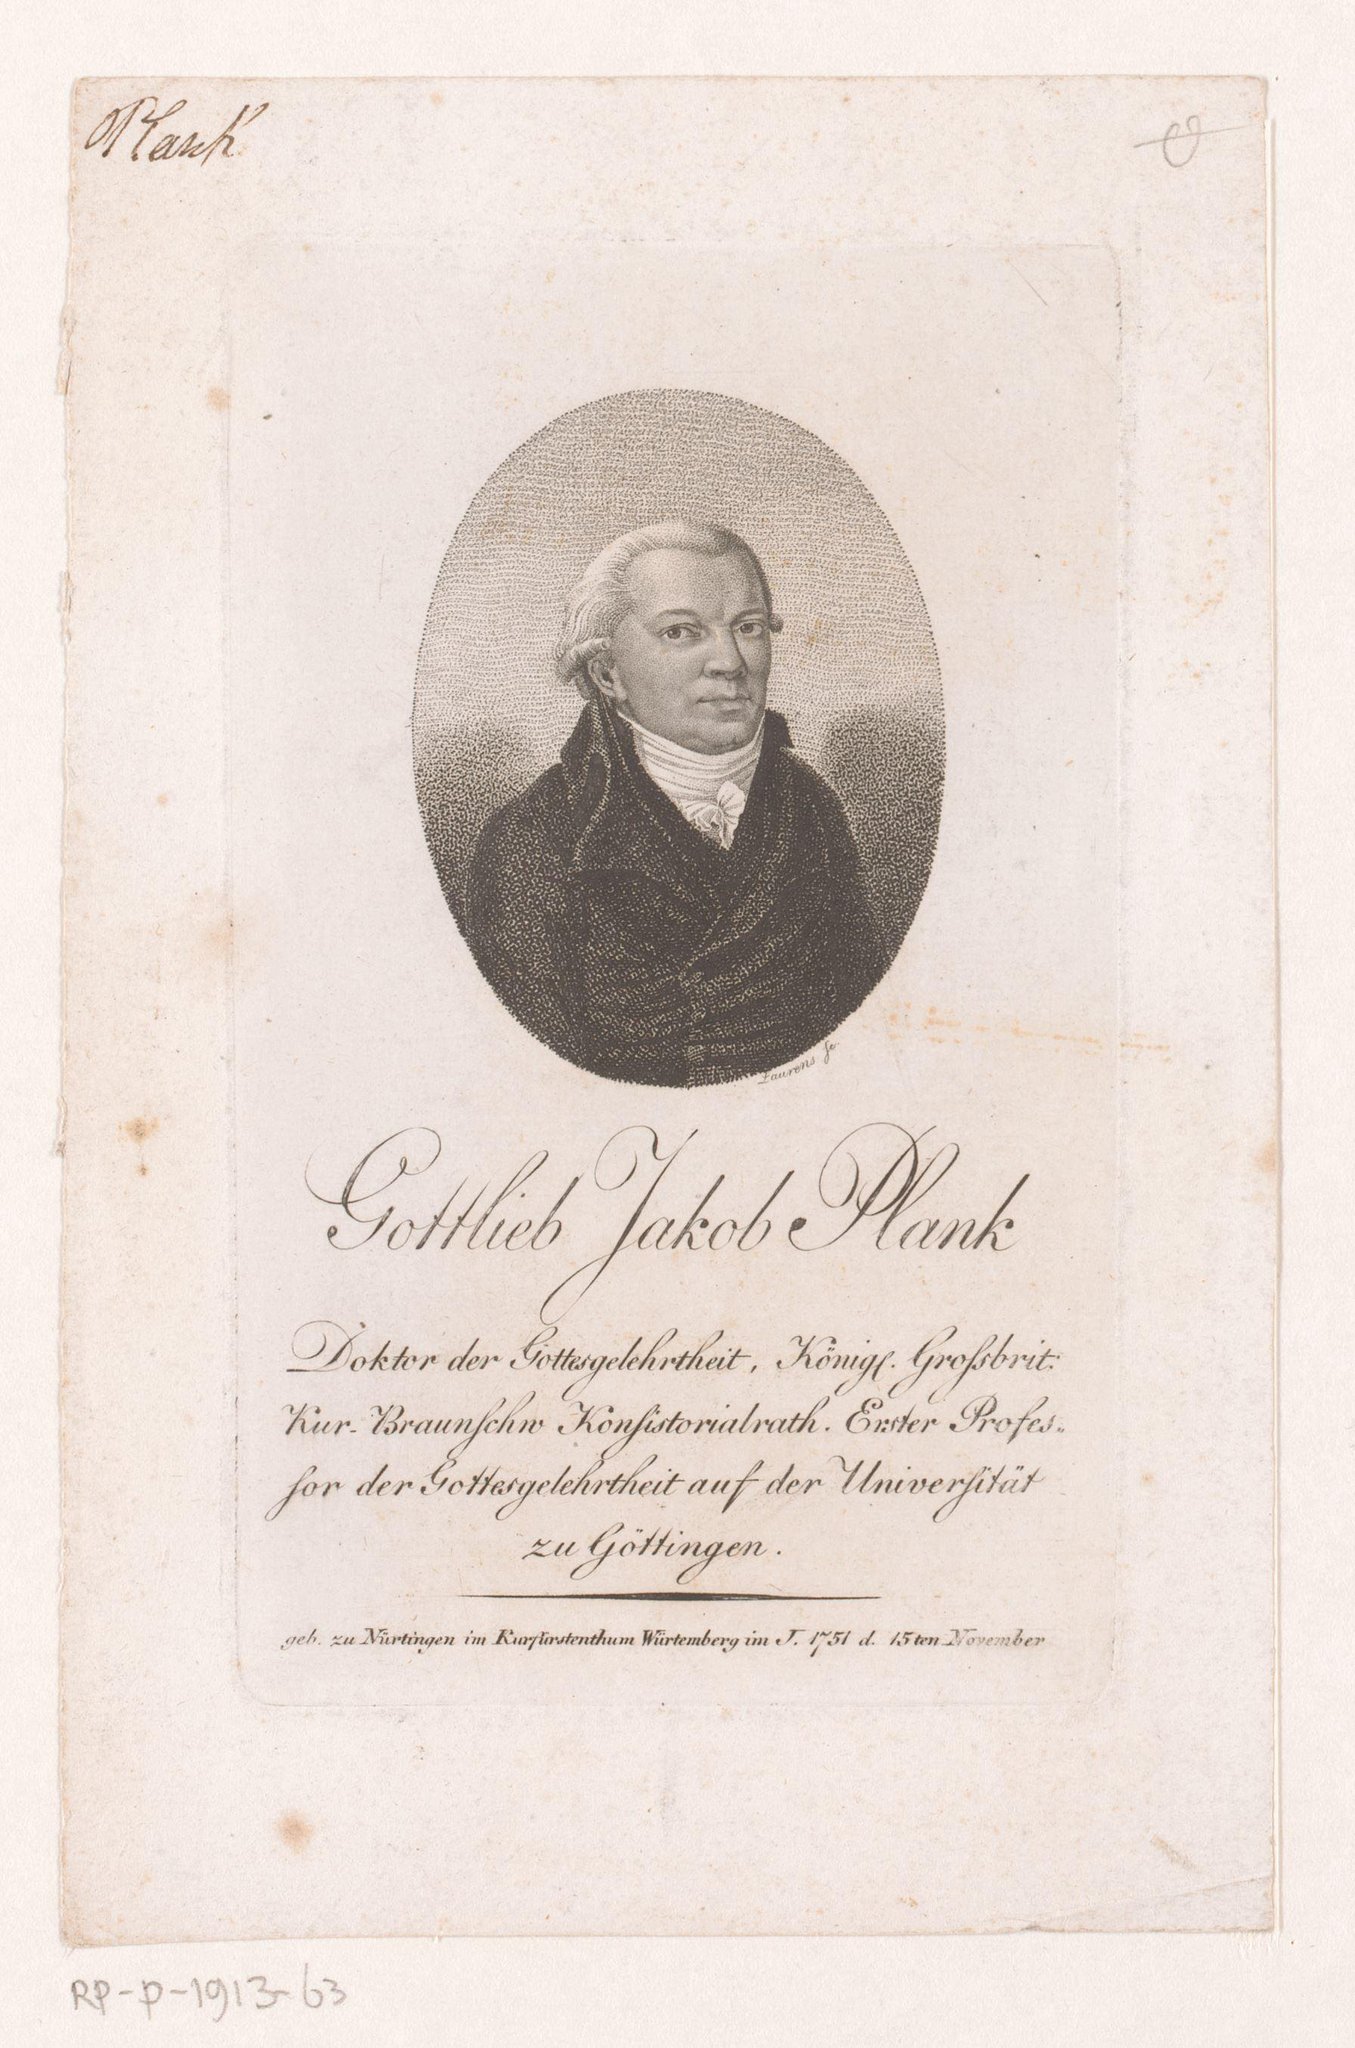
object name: print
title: Portret van Gottlieb Jakob Planck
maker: johann daniel laurenz (ii)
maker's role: draughtsman, print maker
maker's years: 1770-1832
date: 1780-1832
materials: paper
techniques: stippling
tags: theologian, historical persons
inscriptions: collector's mark: Lugt 2228